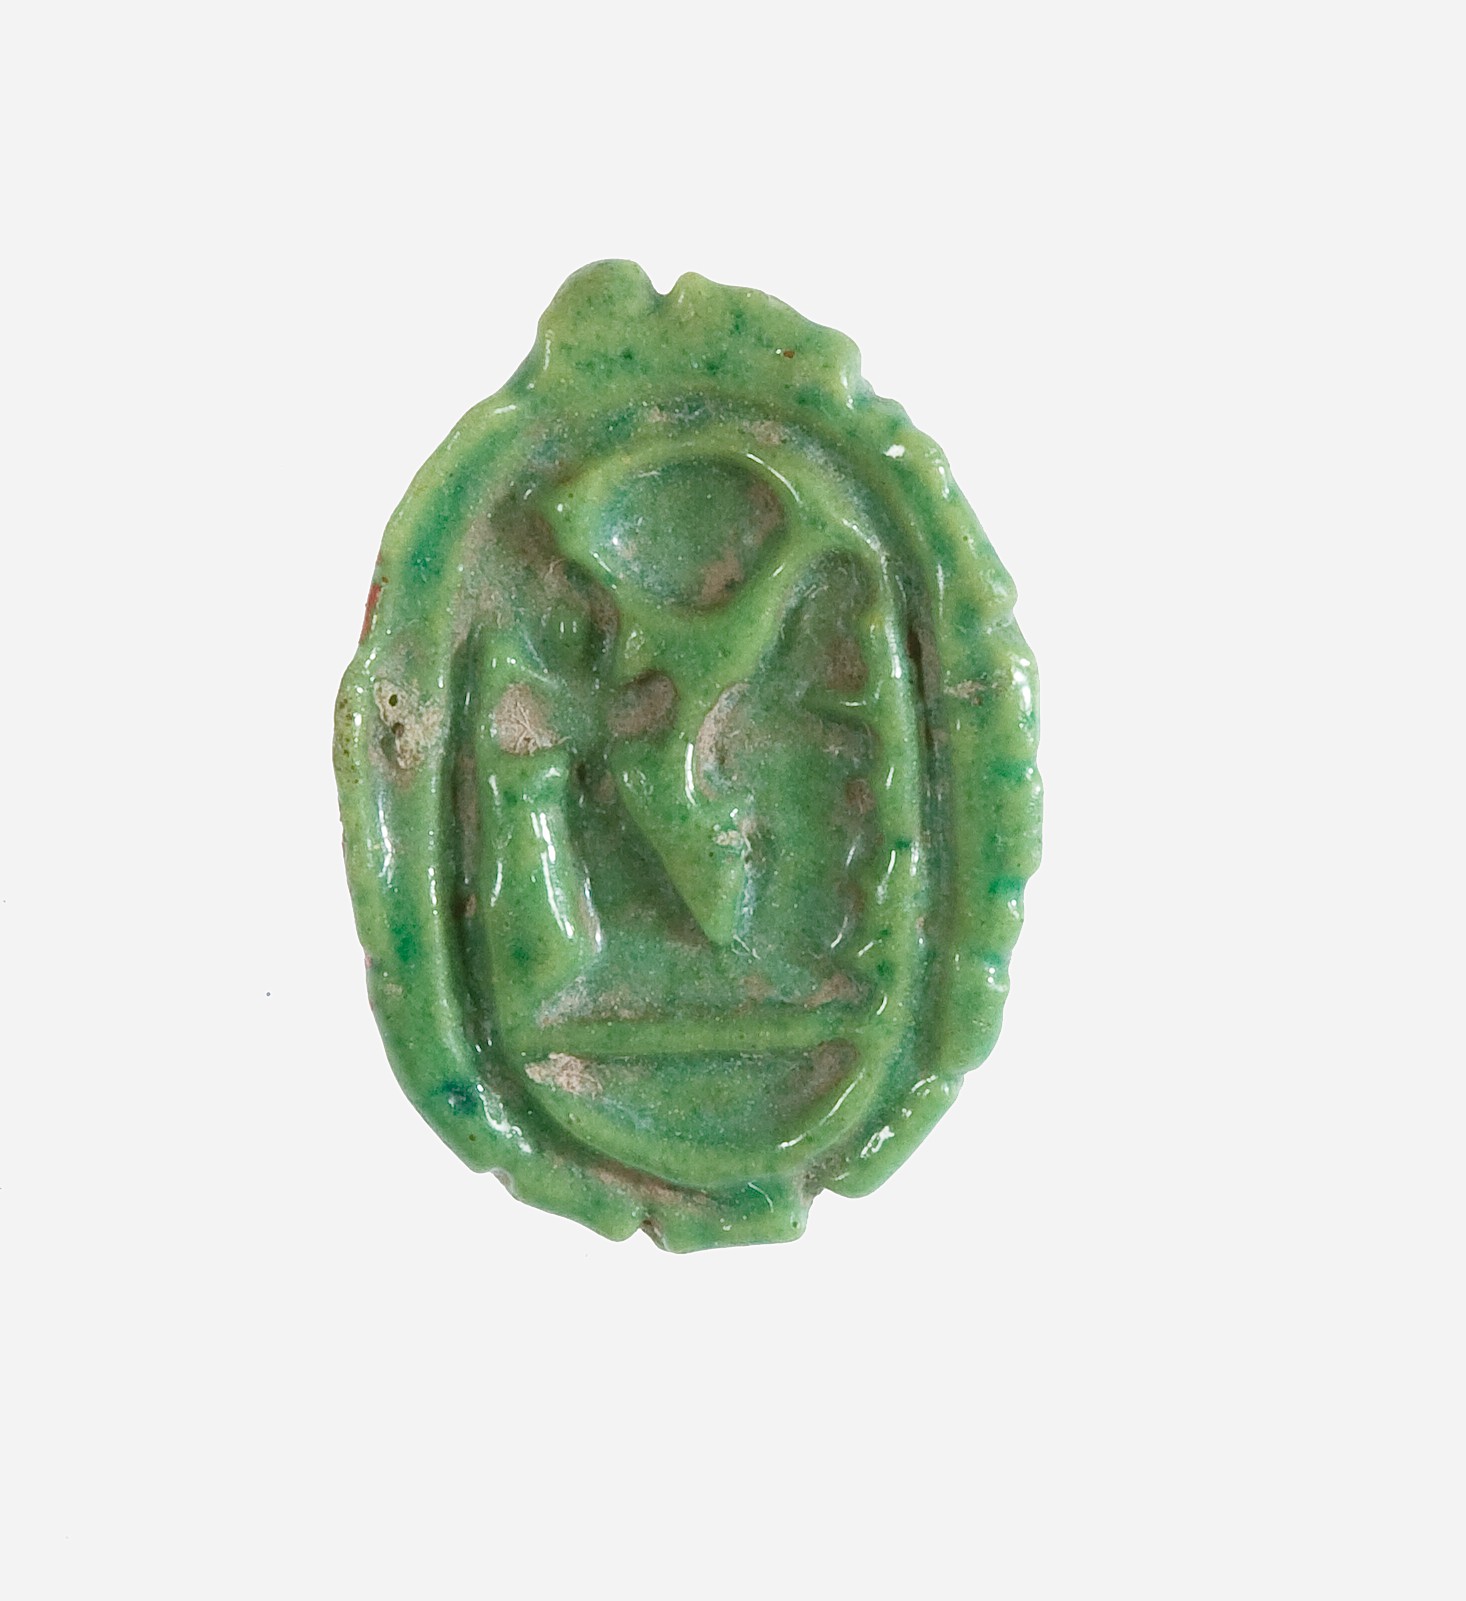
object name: scarab, nebmaatre, amenhotep iii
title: Scarab Inscribed with the Throne Name of Amenhotep III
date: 1390-1352 BCE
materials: faience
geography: egypt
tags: scarabs